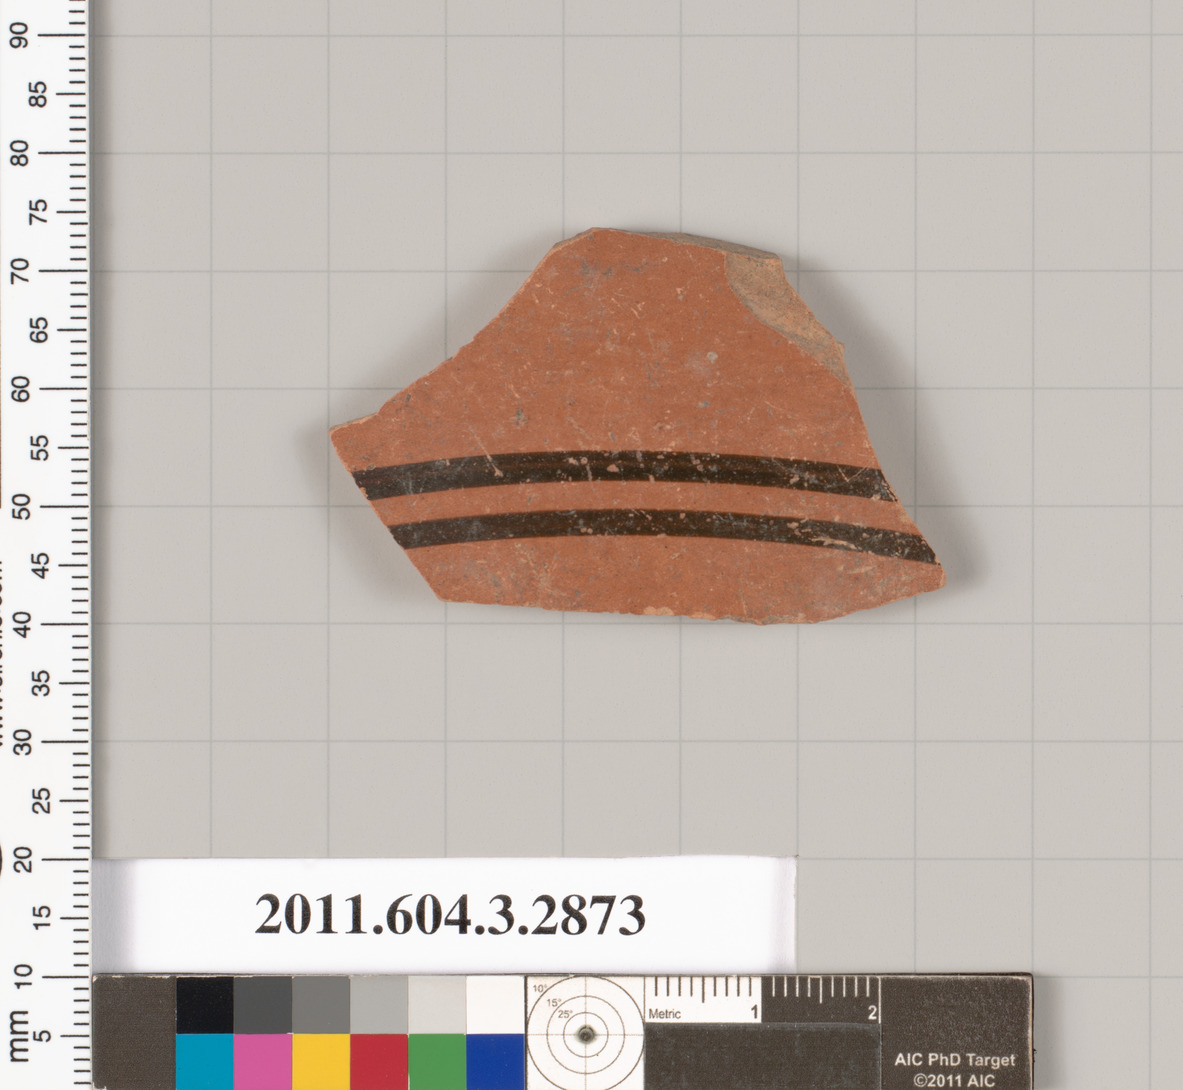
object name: undetermined closed shape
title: Terracotta fragment of a closed shape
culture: greek, attic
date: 600-501 BCE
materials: terracotta